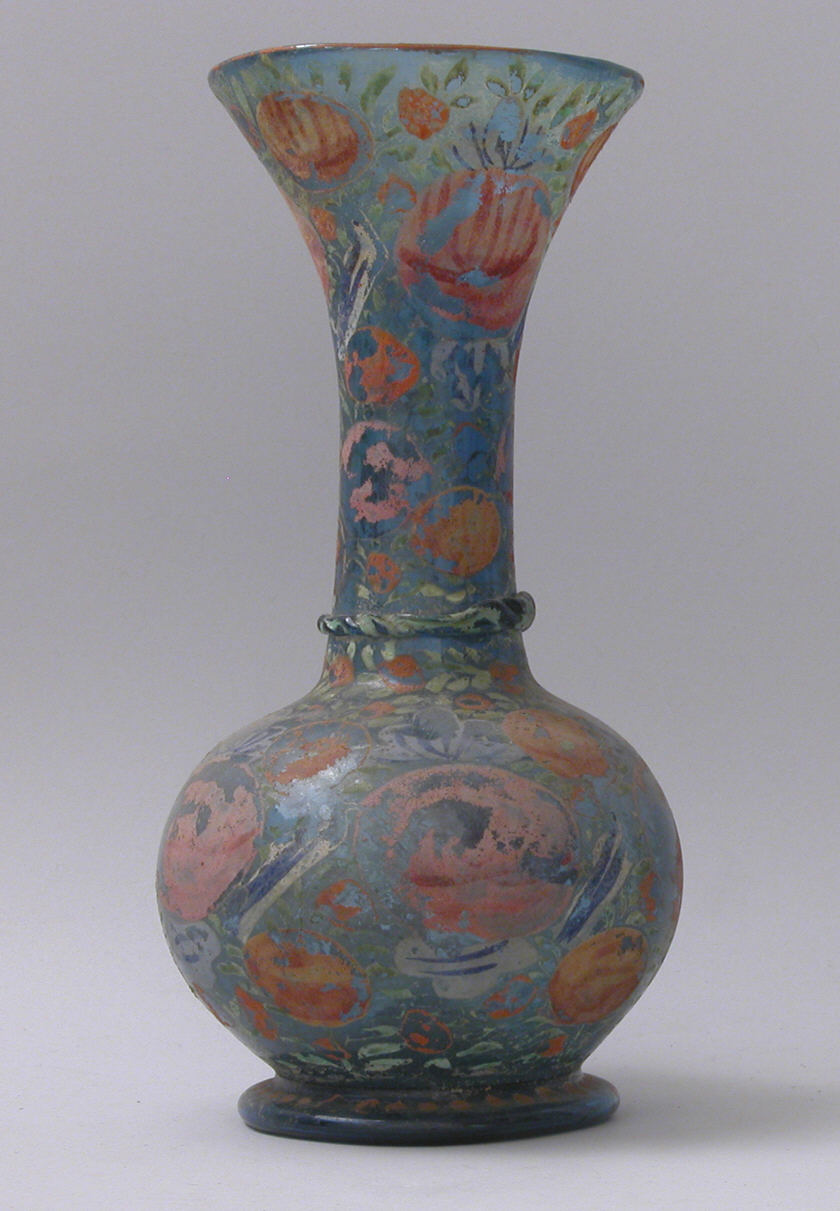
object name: bottle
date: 1701-1900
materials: glass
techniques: glassblowing, painting, tooling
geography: iran